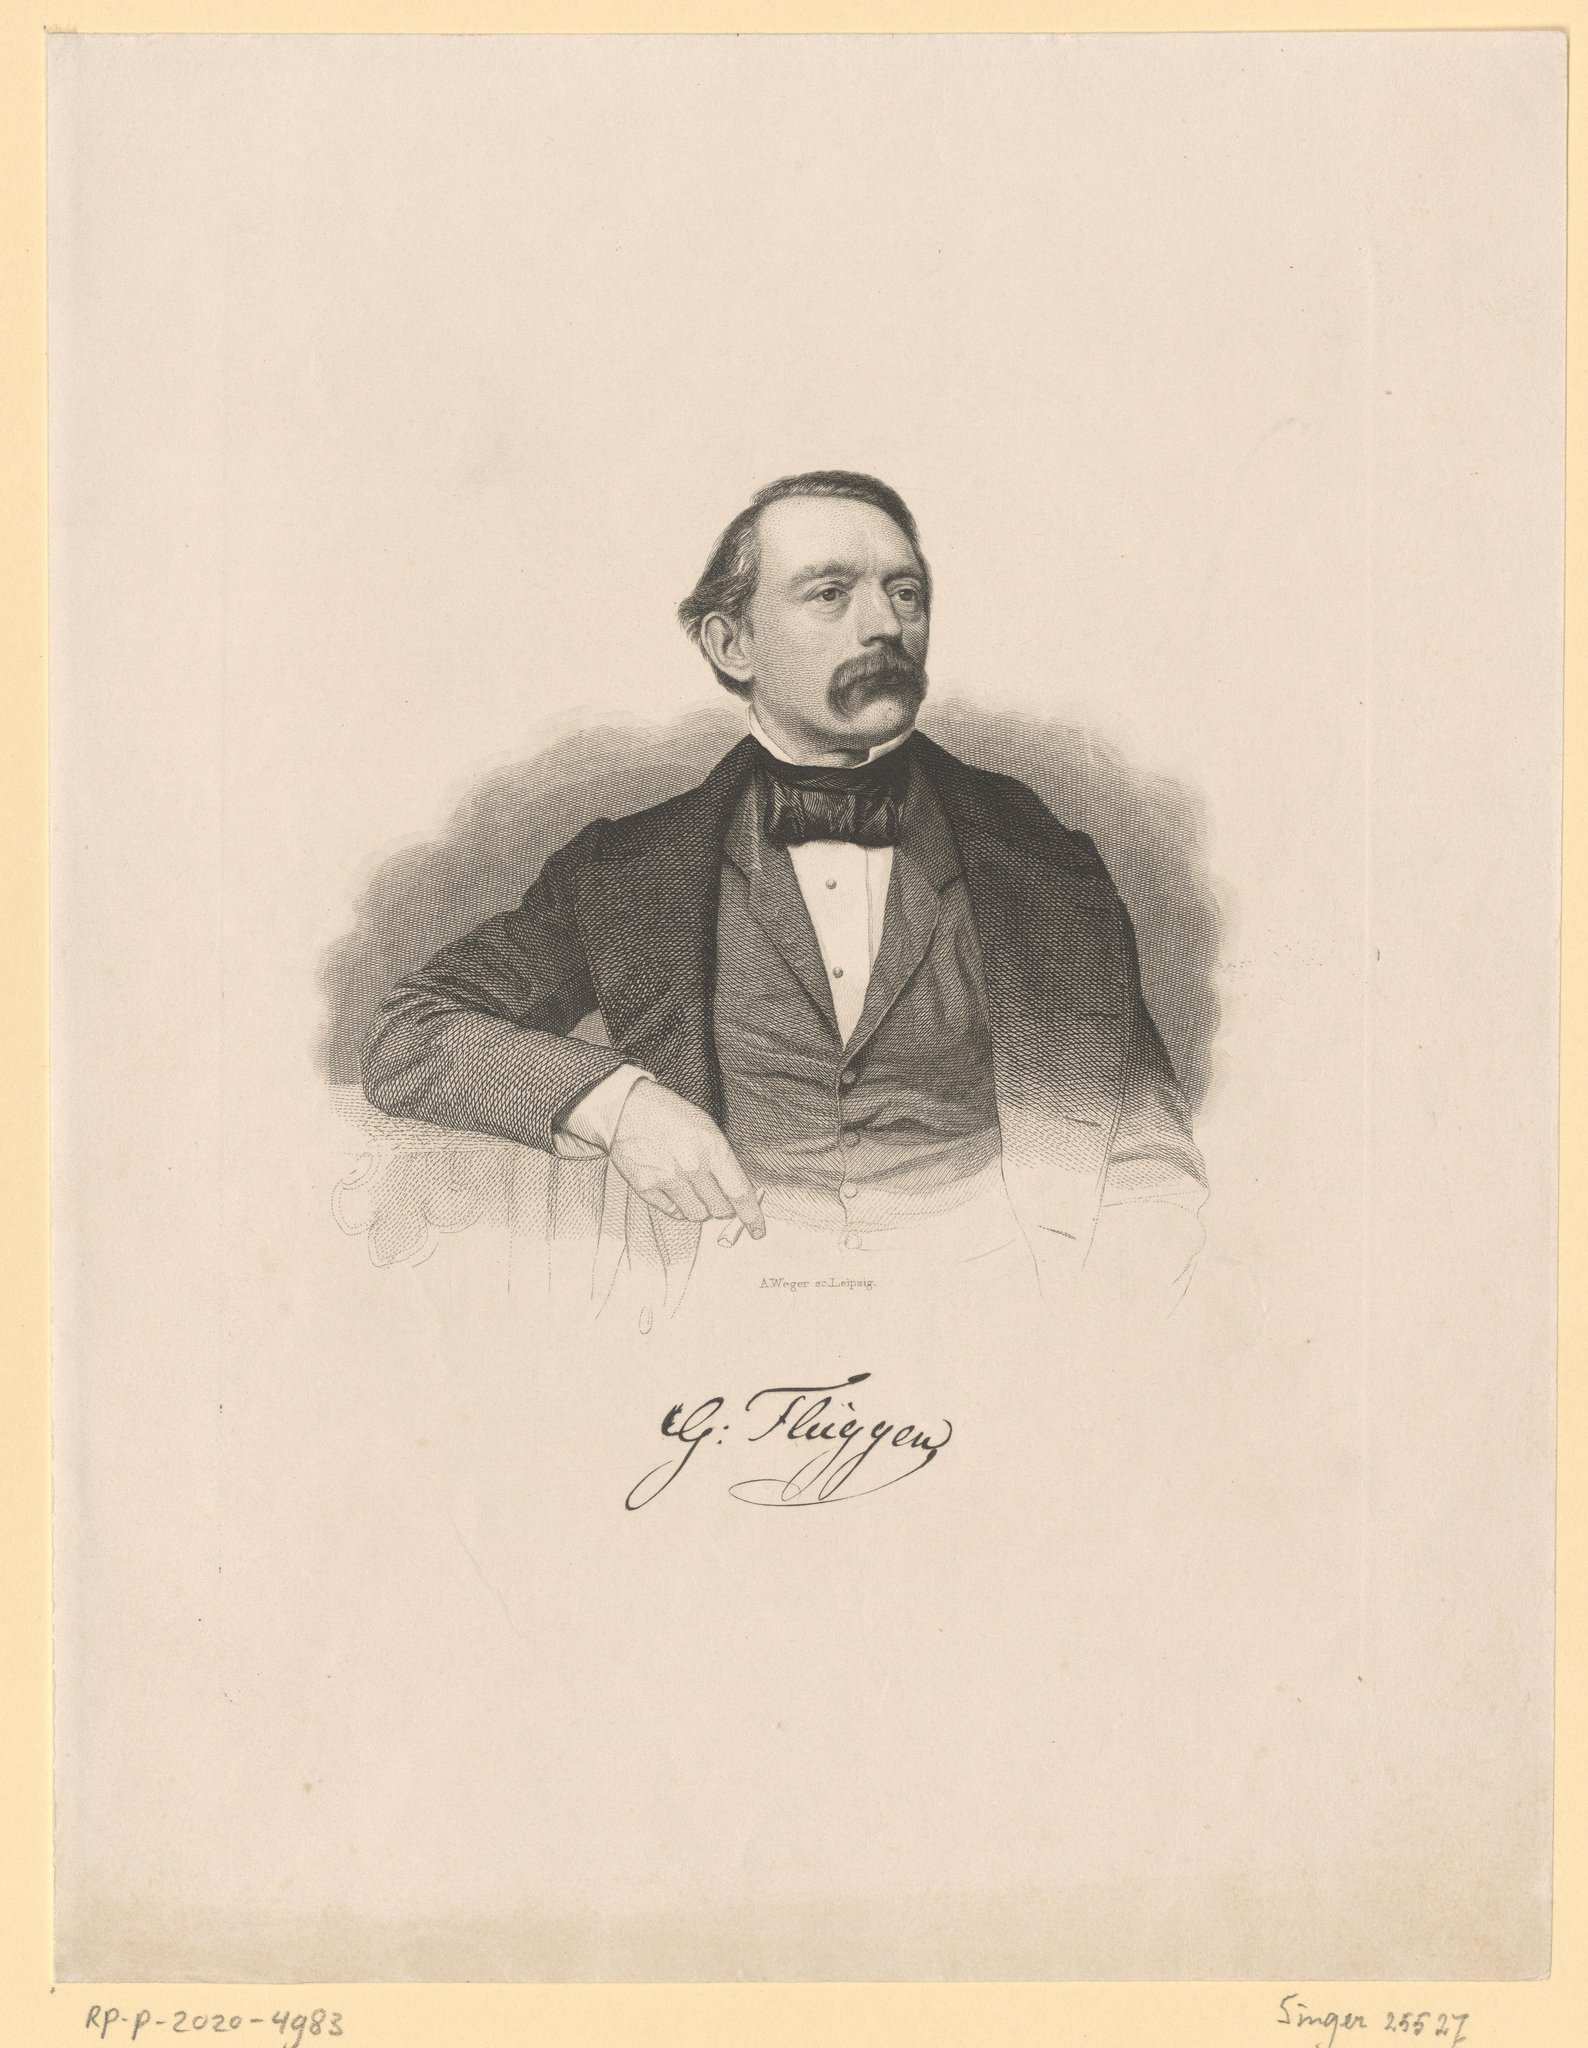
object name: print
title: Portret van Gisbert Flüggen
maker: august weger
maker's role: print maker, printer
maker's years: 1823-1892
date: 1840-1892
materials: paper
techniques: engraving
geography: leipzig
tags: cologne, historical persons, portrait, self-portrait of painter